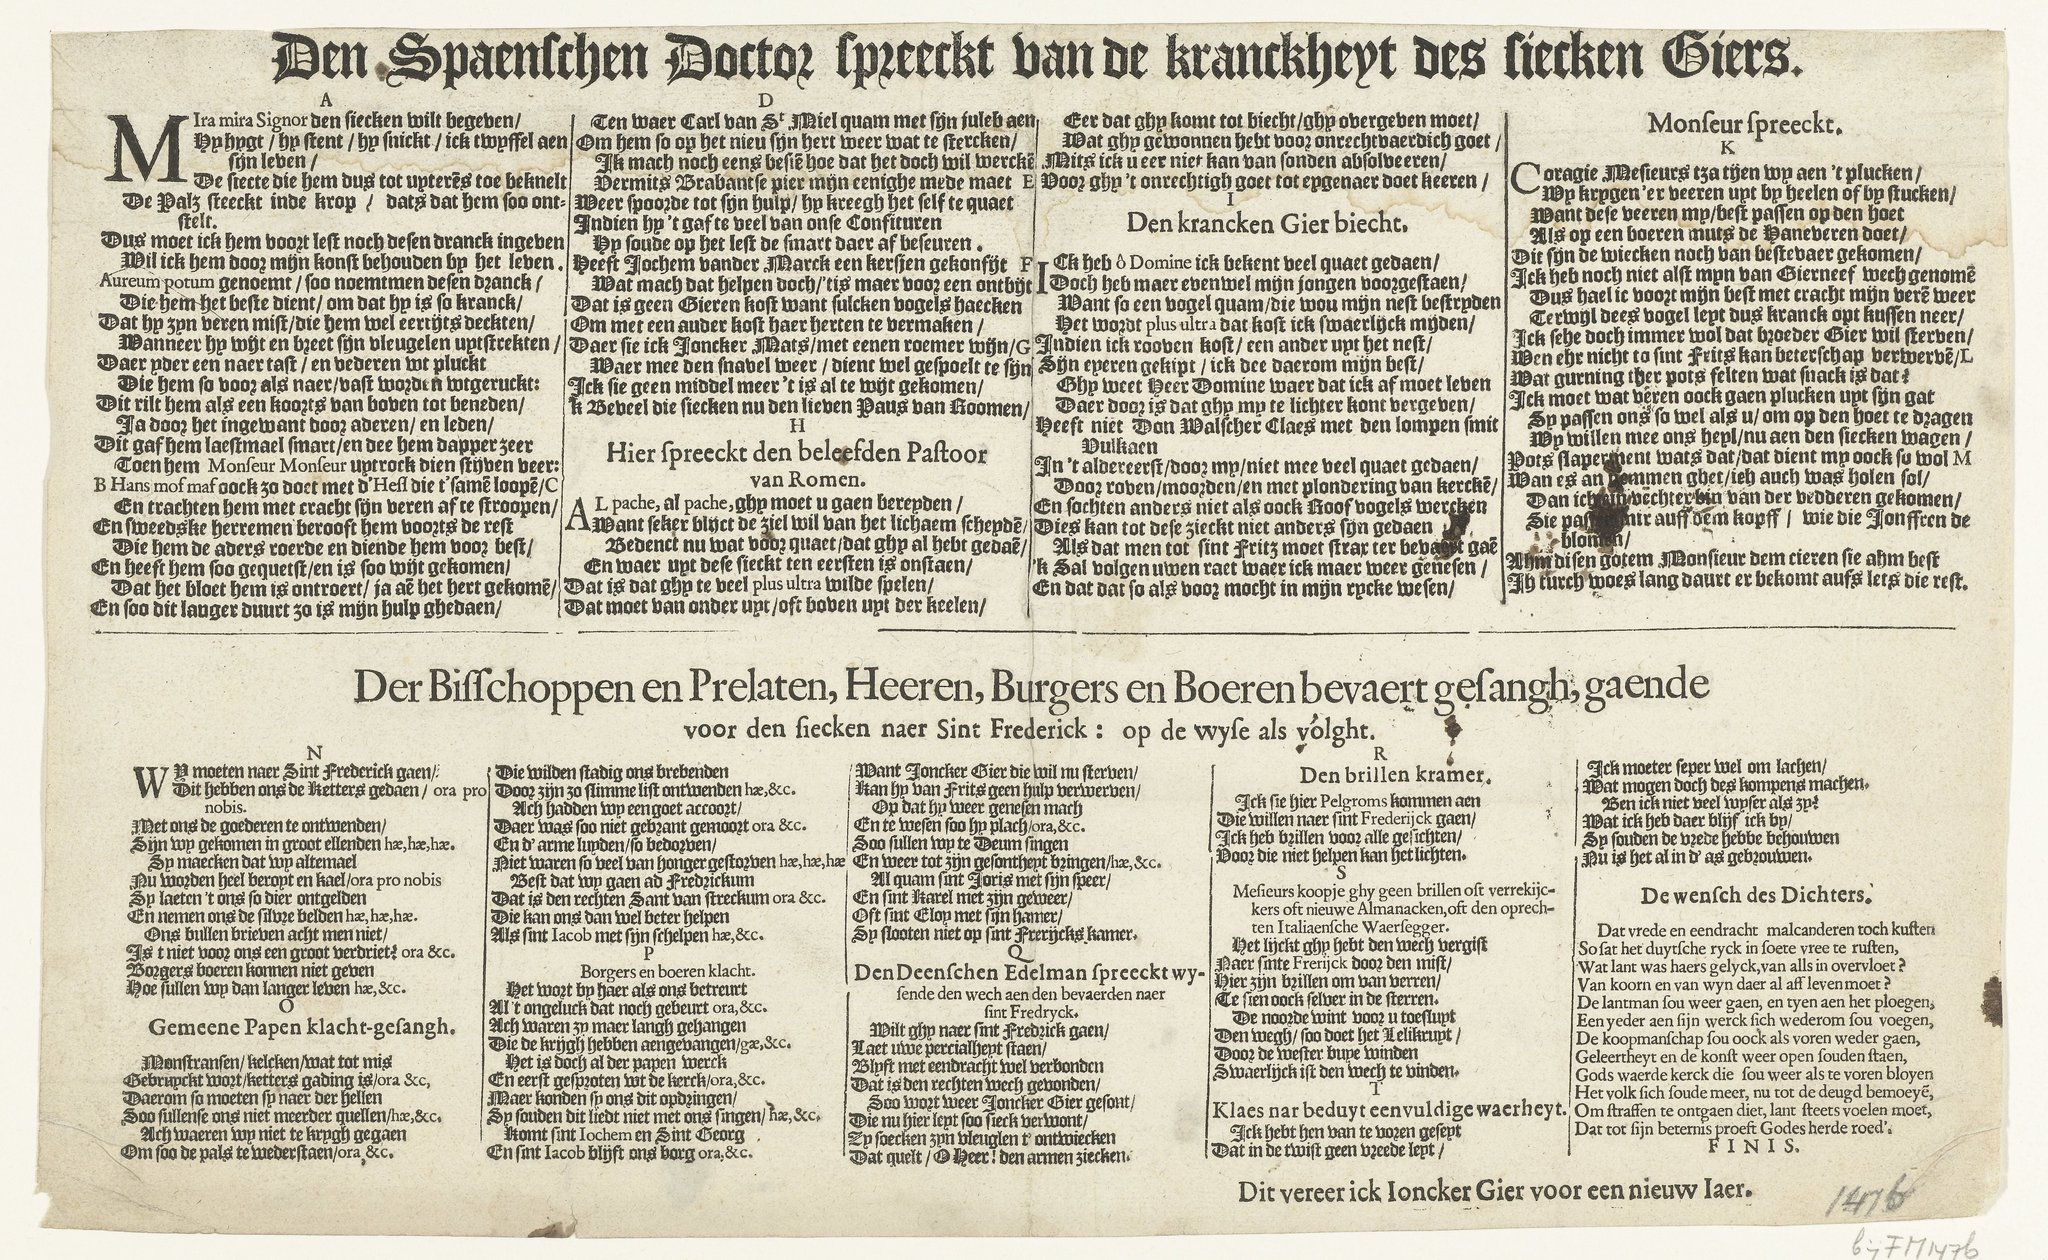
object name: text sheet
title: Den Spaenschen Doctor spreeckt van de kranckheyt des siecken Giers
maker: Anonymous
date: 1622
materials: paper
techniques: letterpress printing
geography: low countries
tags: amberg, frederik v (keurvorst van de palts, koning van bohemen)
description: Tekstblad bij de nieuwjaarsprent en spotprent op de val van Frederik van de Palts, koning van Bohemen, 1622.